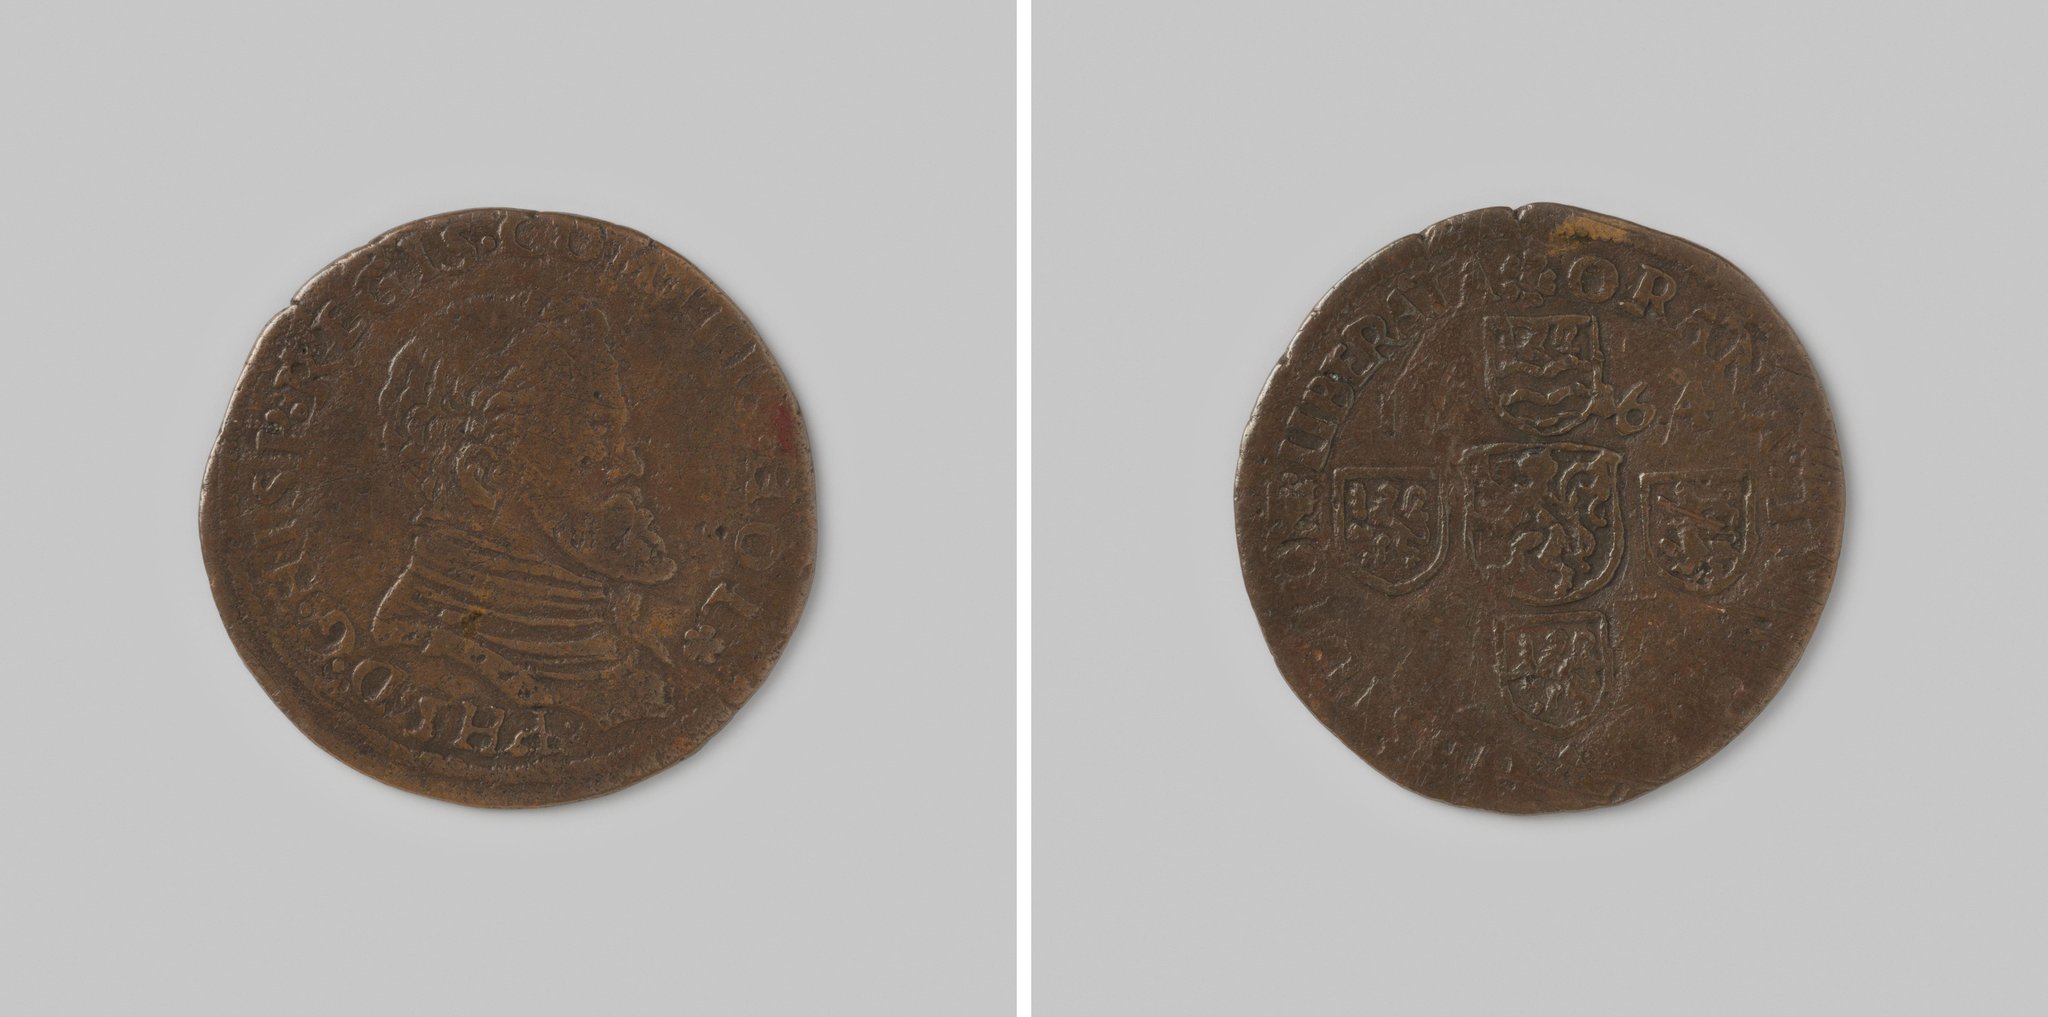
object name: history medal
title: Rekenpenning uit Dordrecht op het ontzet van Oran 1564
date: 1564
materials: copper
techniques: striking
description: Kperen penning, op de voorzijde het borstbeeld van Philips II naar rechts met omschrift, op de keerzijde vijf wapens in kruisvorm met jaartal in het veld en omschrift.